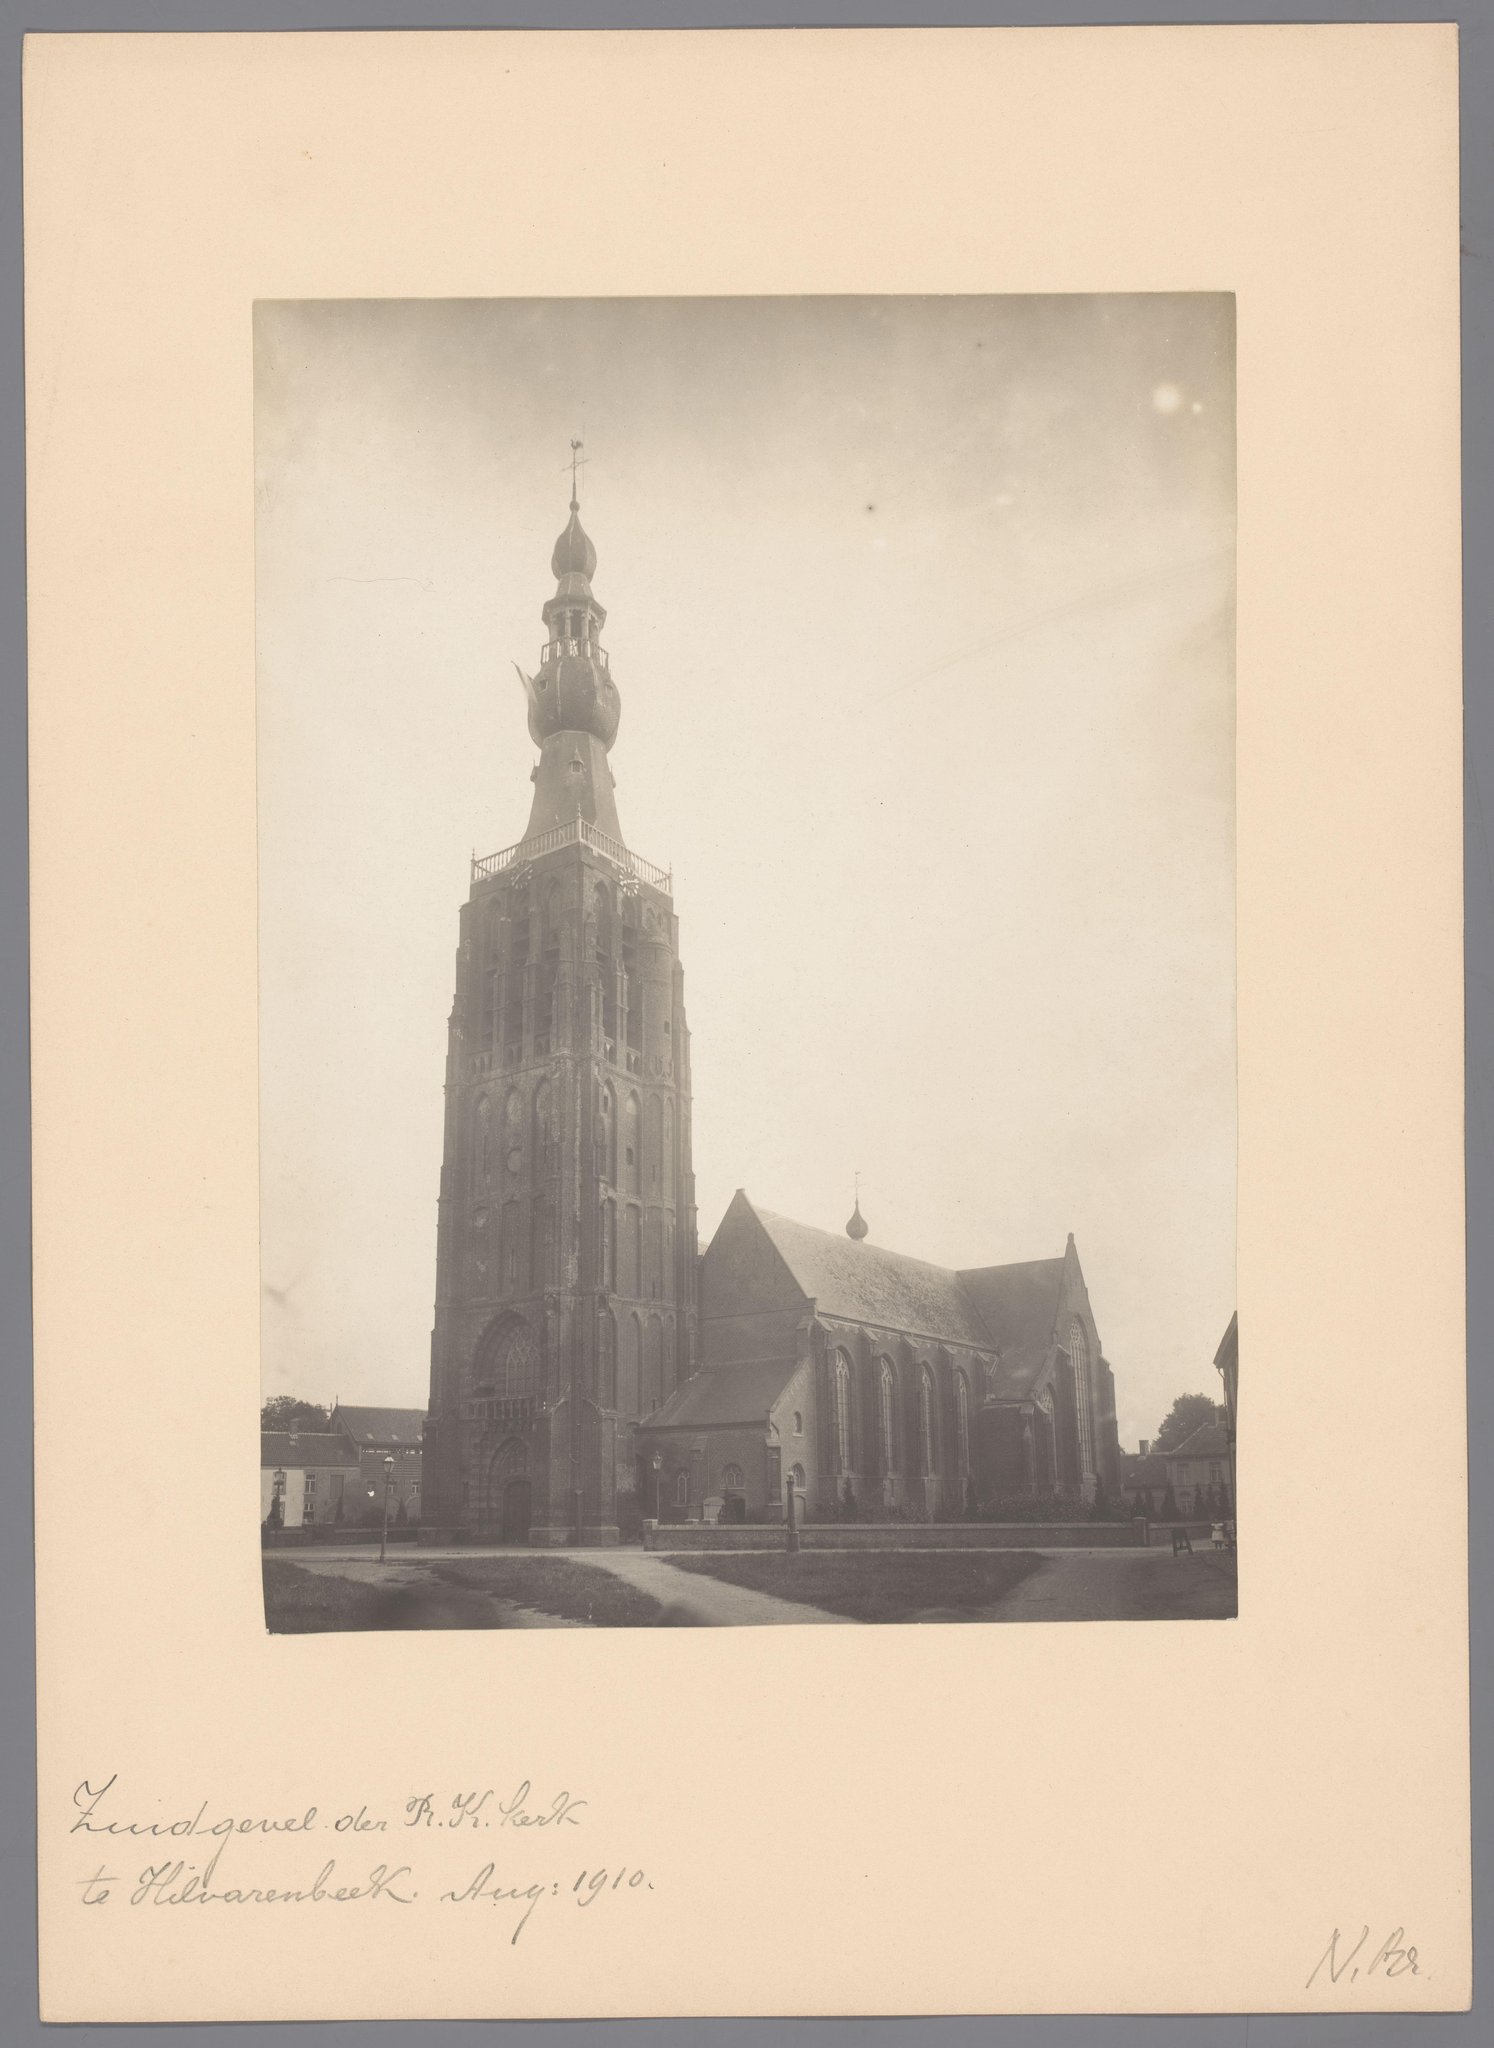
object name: photograph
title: Gezicht op de Sint-Petrus'-Bandenkerk te Hilvarenbeek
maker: anoniem (monumentenzorg)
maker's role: fotograaf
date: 1910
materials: cardboard, photographic support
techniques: gelatin silver print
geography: hilvarenbeek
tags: church (exterior)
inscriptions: annotation: ‘Zuidgevel der R.K. Kerk te Hilvarenbeek. Aug: 1910/ N.Br.’